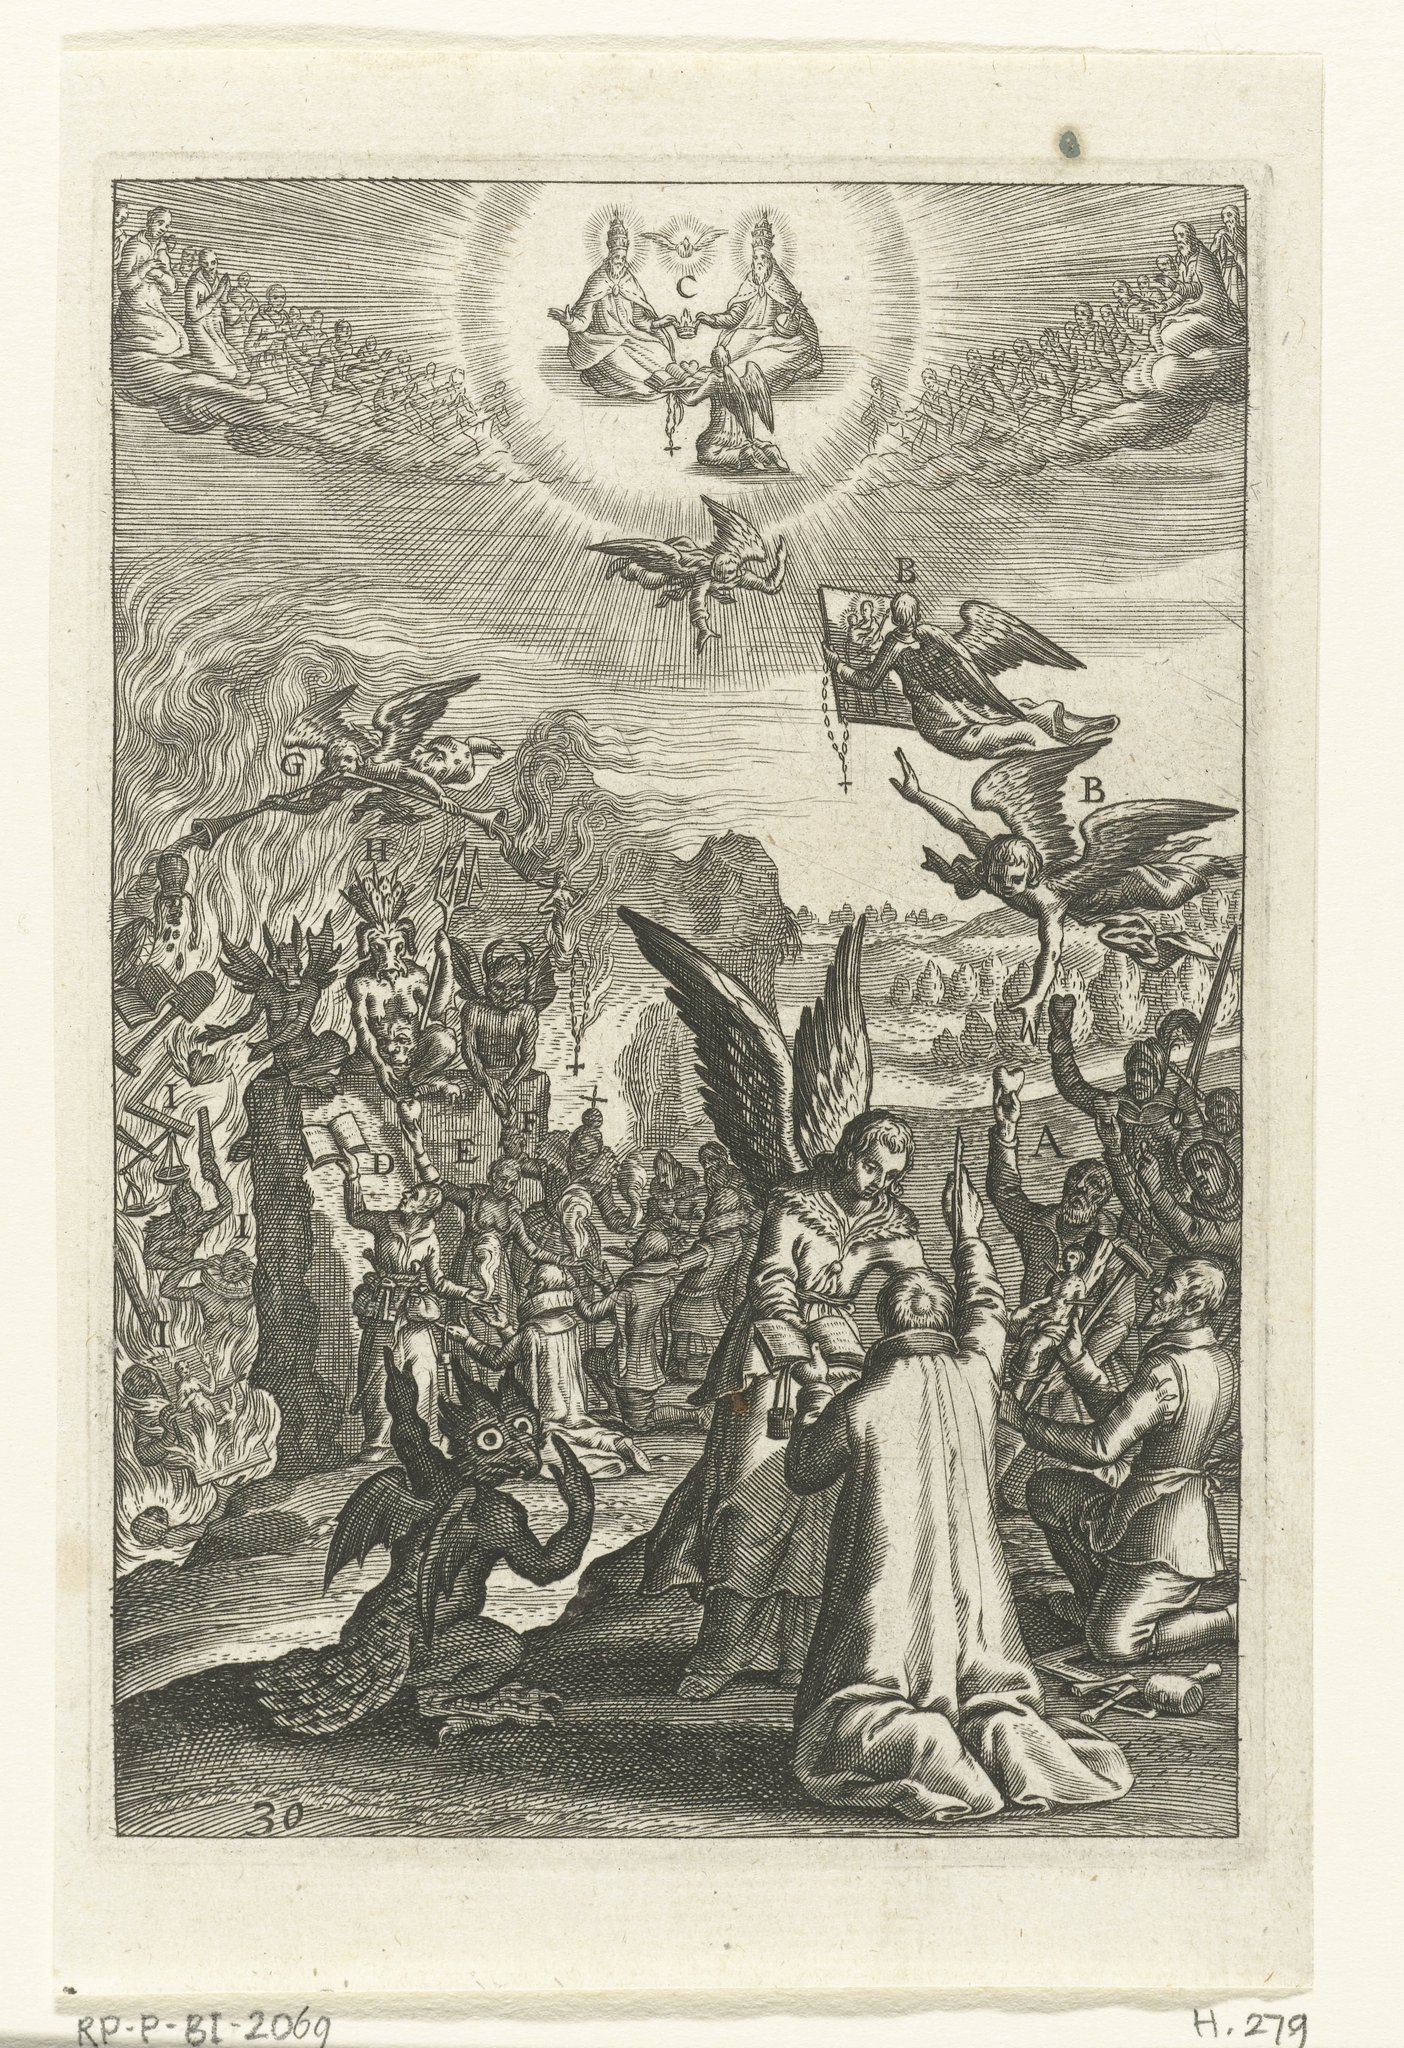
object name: book illustration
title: Embleem met man die leert dat hij met goede werken God behaagt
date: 1620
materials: paper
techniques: engraving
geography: low countries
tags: the life of man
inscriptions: collector's mark: Lugt 2228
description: Prent uit: Antoine Sucquet, Den wech des eeuwich levens, beschreven int latijn : met beelden verlicht door Boëtius a Bolsvert, Antwerpen, Hendrick Aertssens, 1620, afb. 666